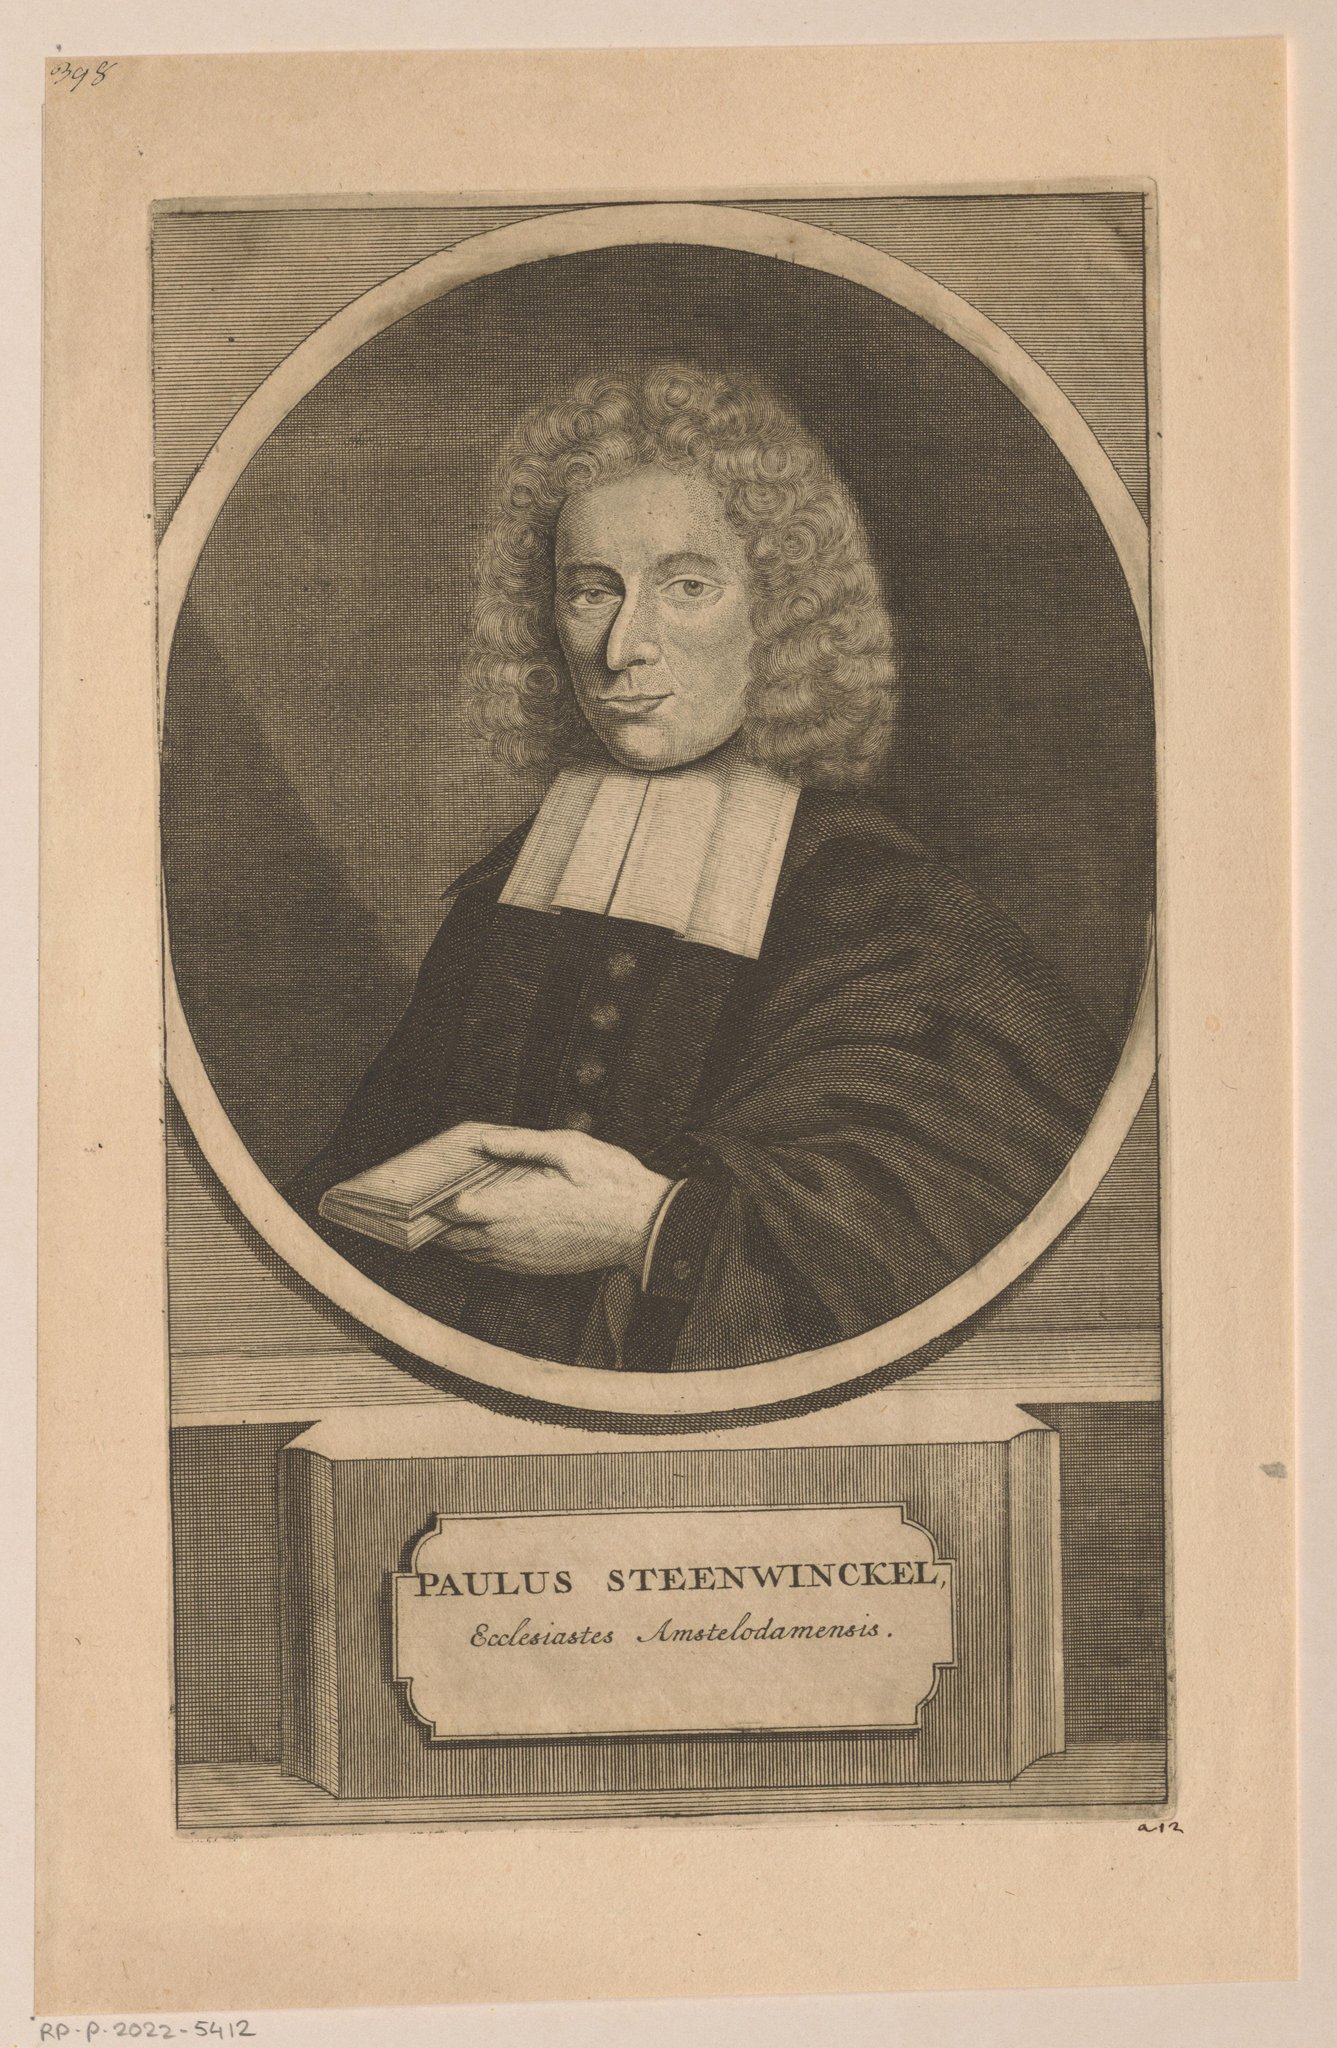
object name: print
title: Portret van Paulus Steenwinkel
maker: Anonymous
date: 1692-1799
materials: paper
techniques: engraving, etching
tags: wijk bij duurstede, amsterdam, theologian, historical persons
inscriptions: inscription: ‘a12’, number: ‘398’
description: Met eenregelig onderschrift in het Latijn.